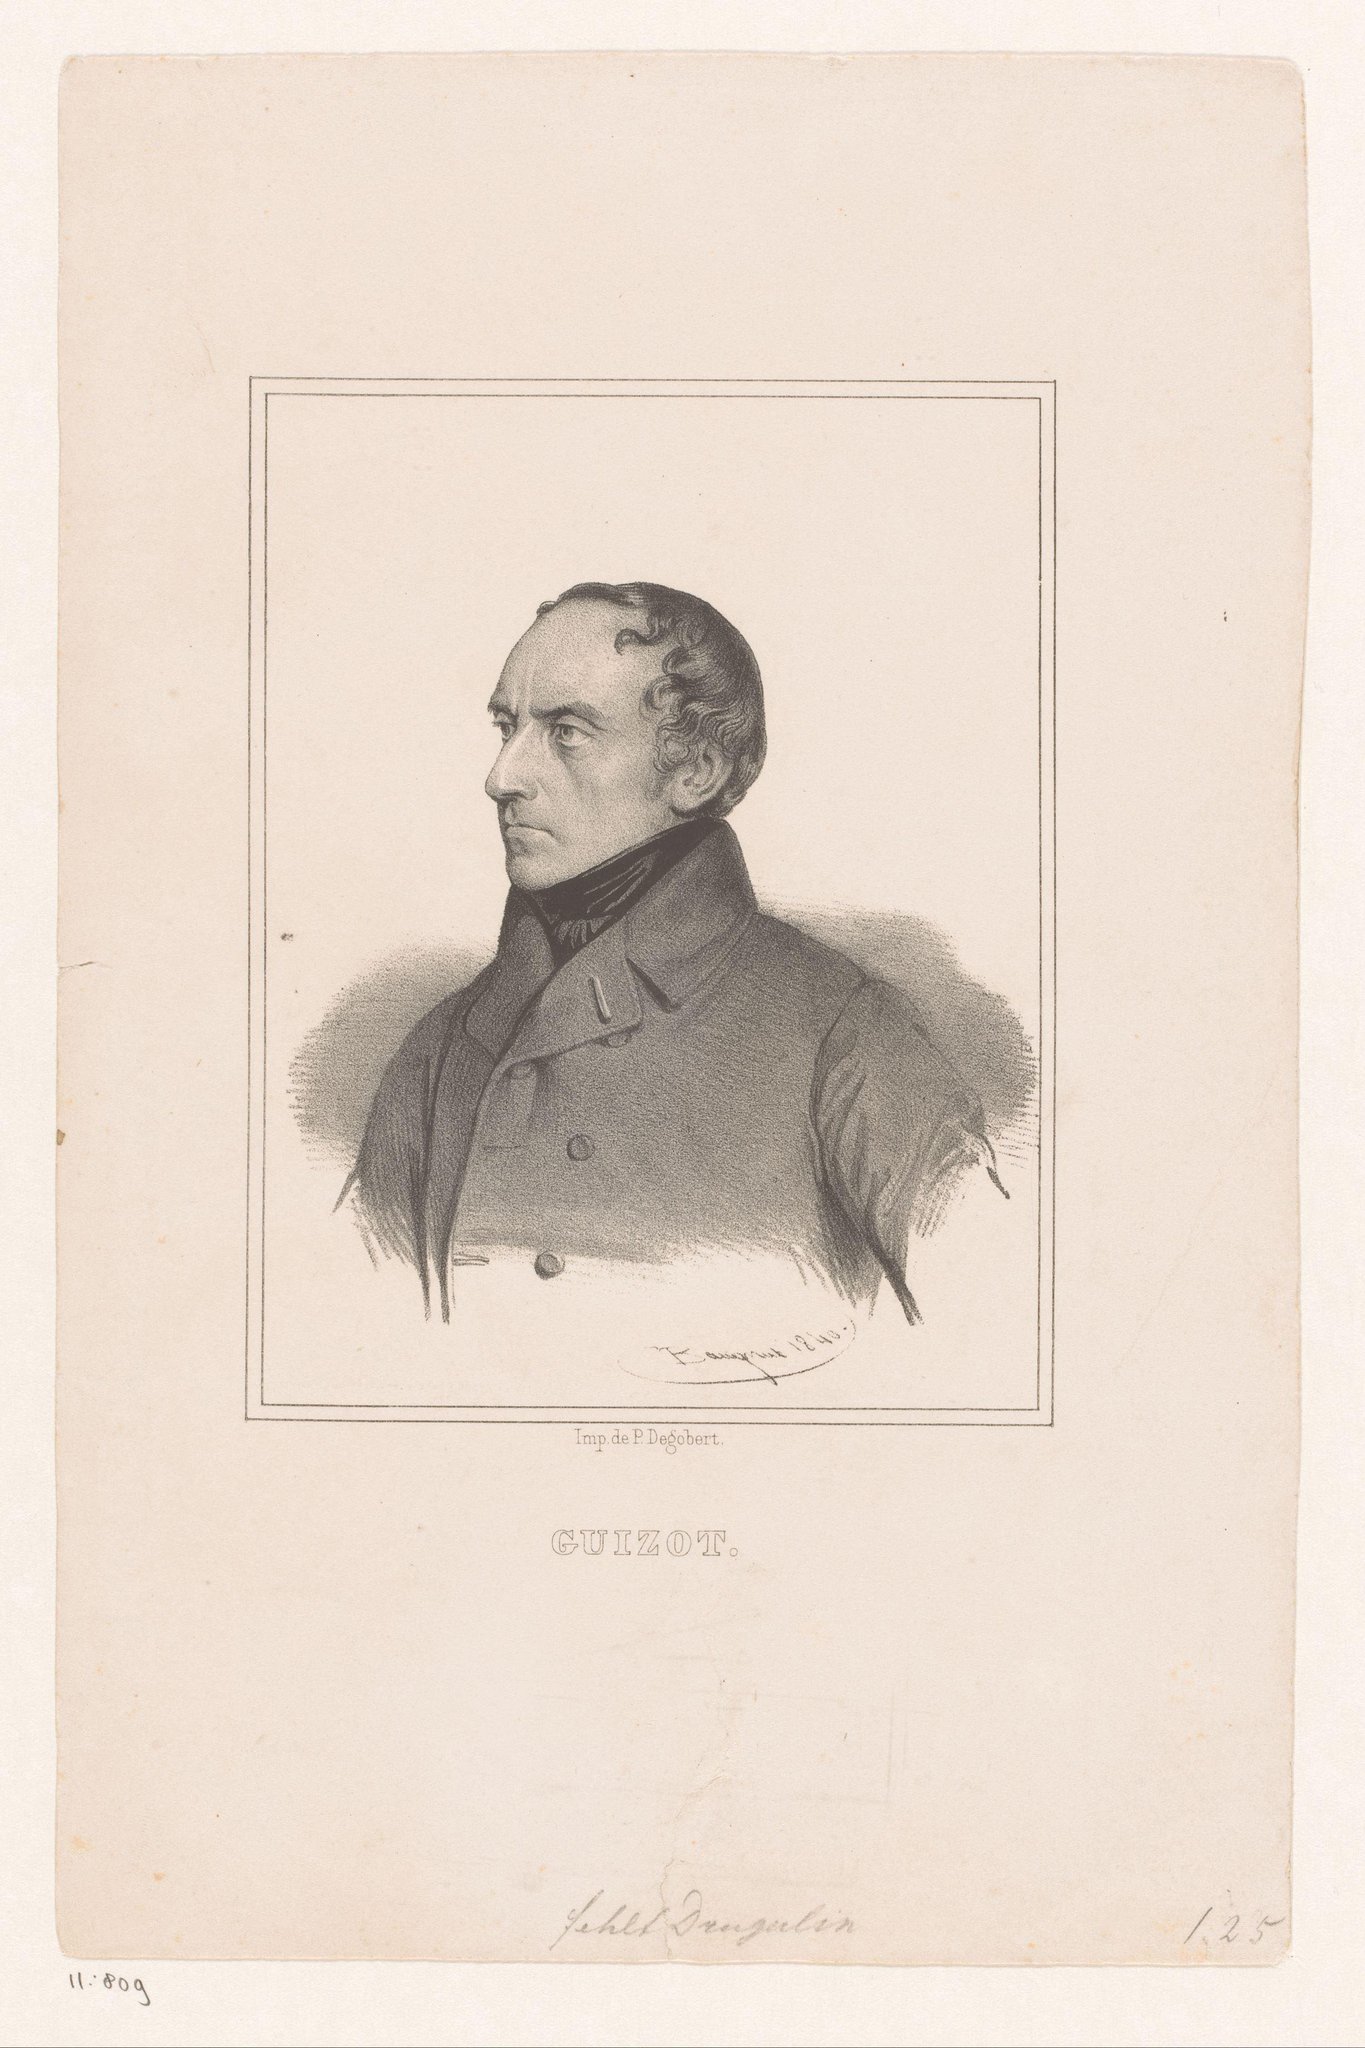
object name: print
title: Guizot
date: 1840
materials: paper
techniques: lithograph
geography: brussels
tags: adult man, historical persons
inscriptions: collector's mark: Lugt 2228